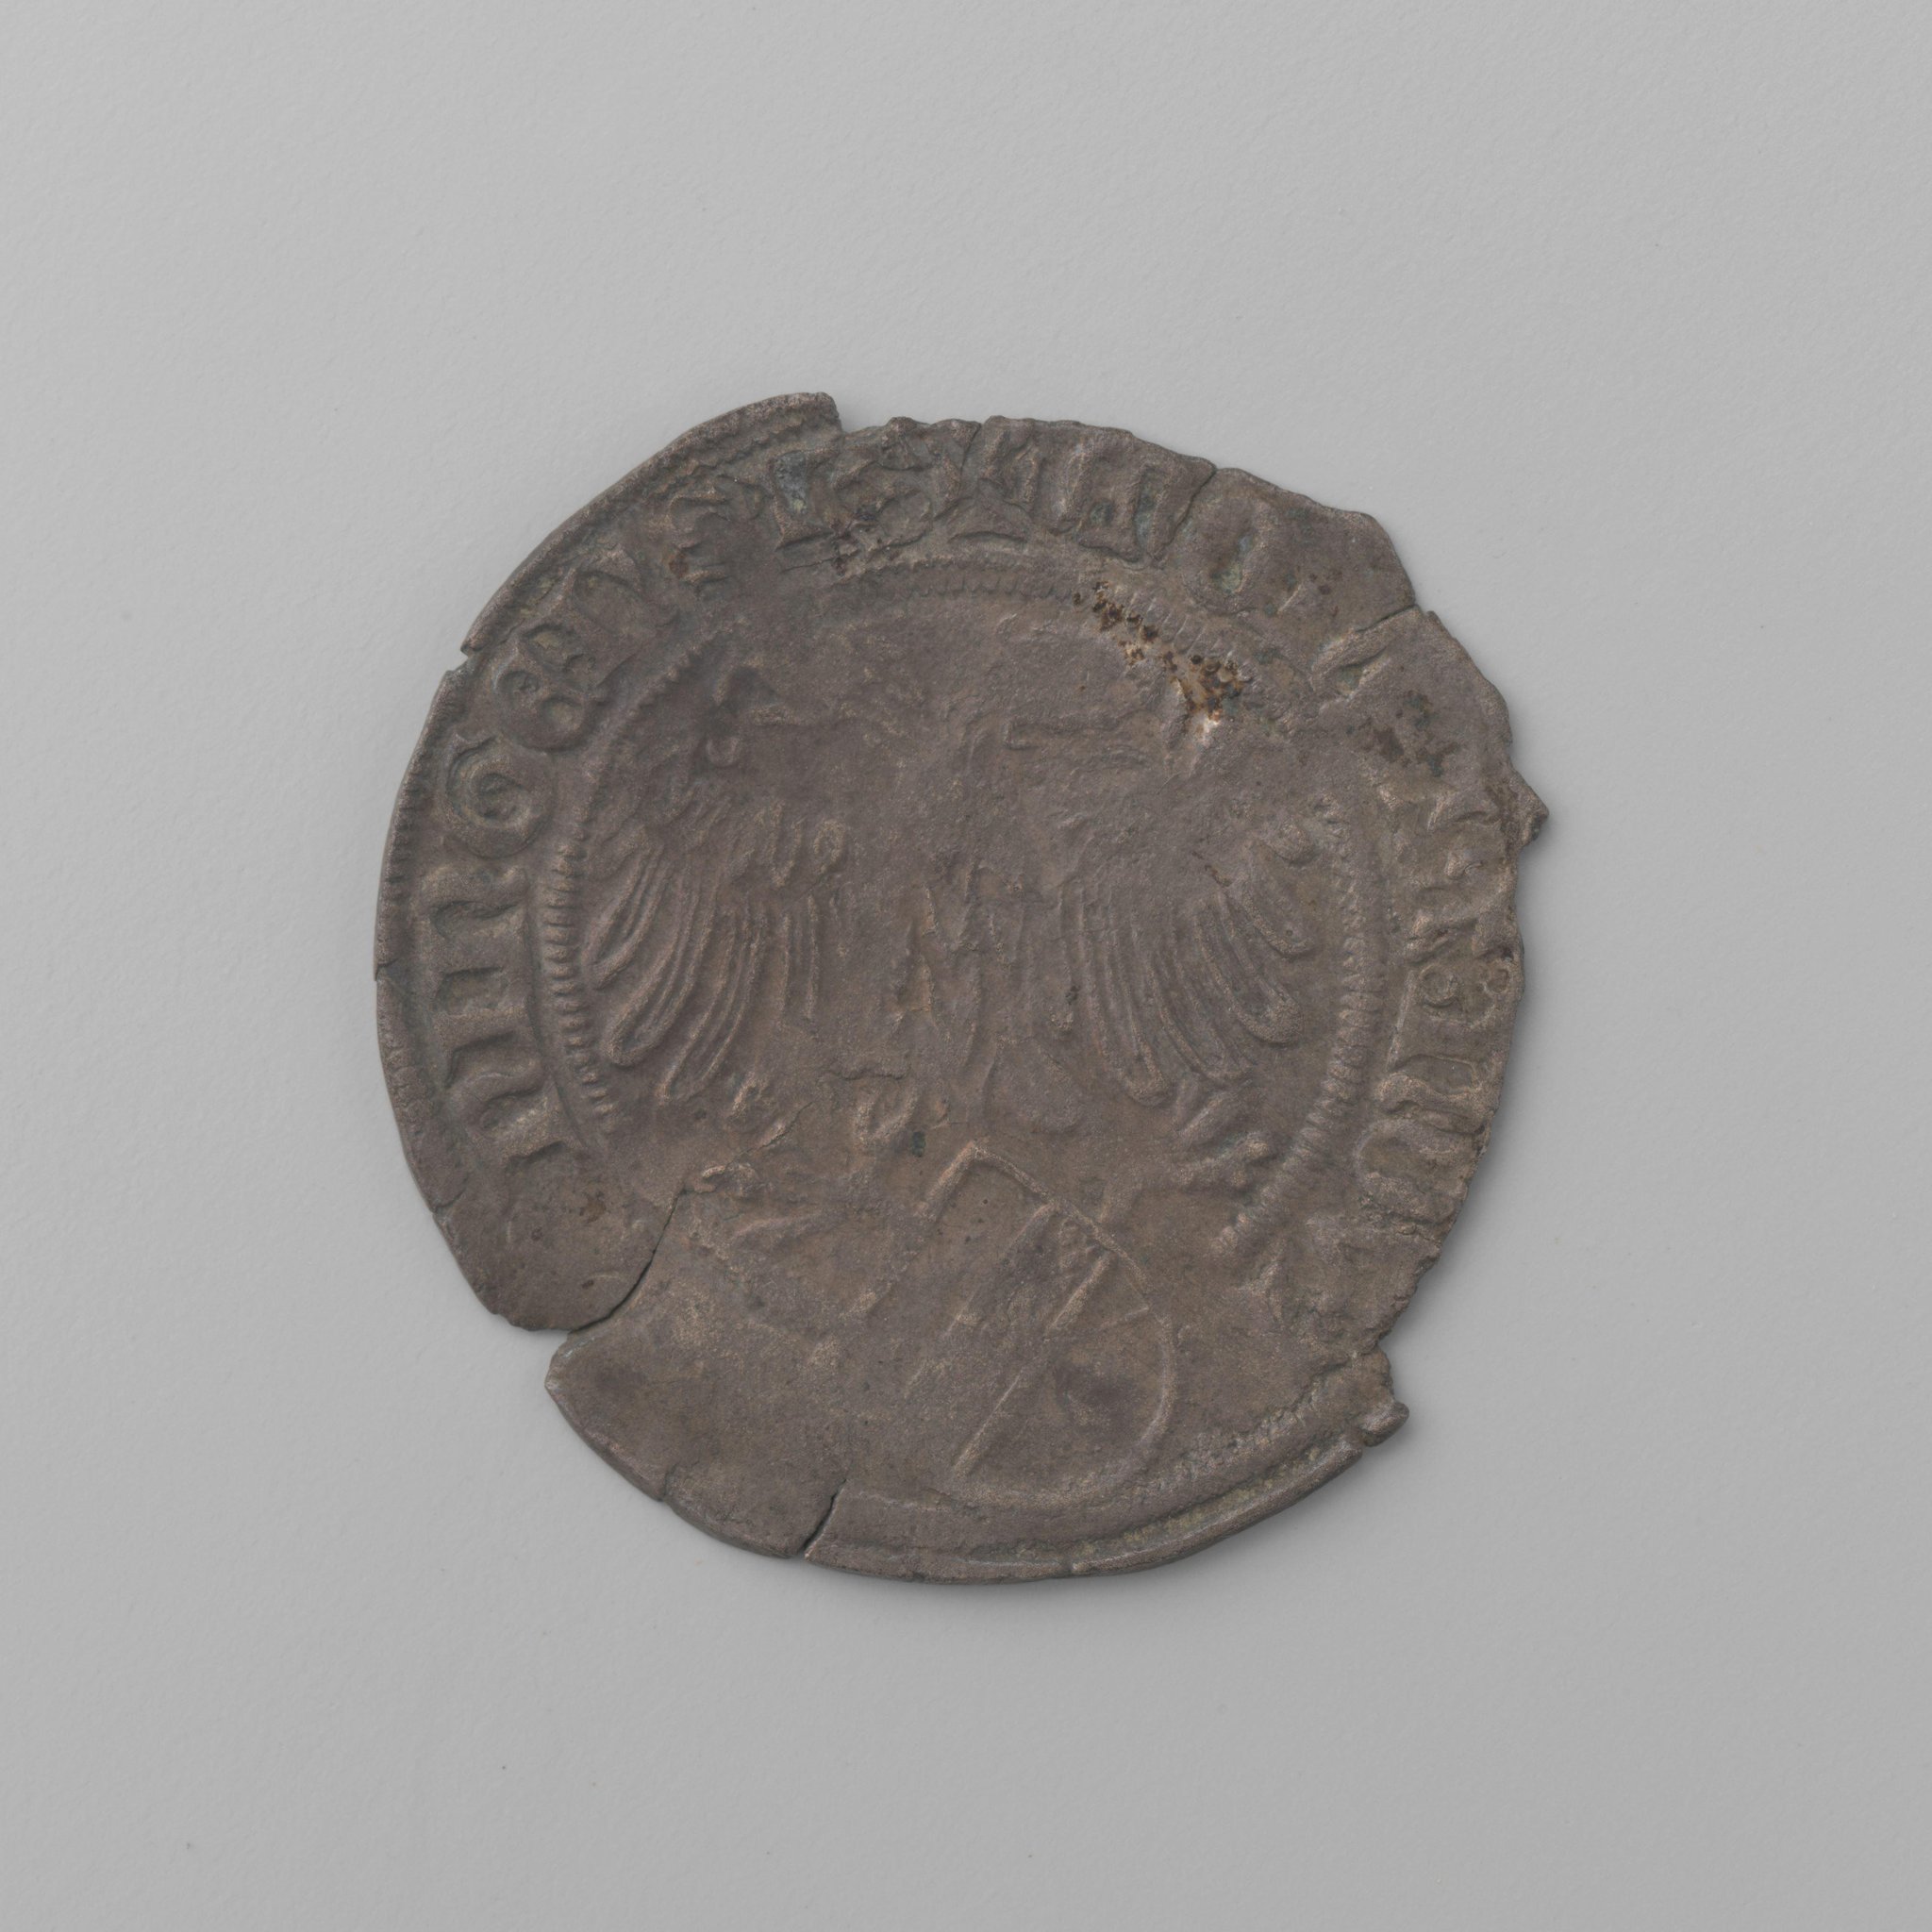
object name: coin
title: Groningse vlieger, 1476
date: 1476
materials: silver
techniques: striking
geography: groningen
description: Zilveren munt. Voorzijde: enkelkoppige adelaar, waaronder schuin geplaatst wapenschild. Keerzijde: lang versierd gevoet kruis, in het hart letter G. Jaartal in omschrift.